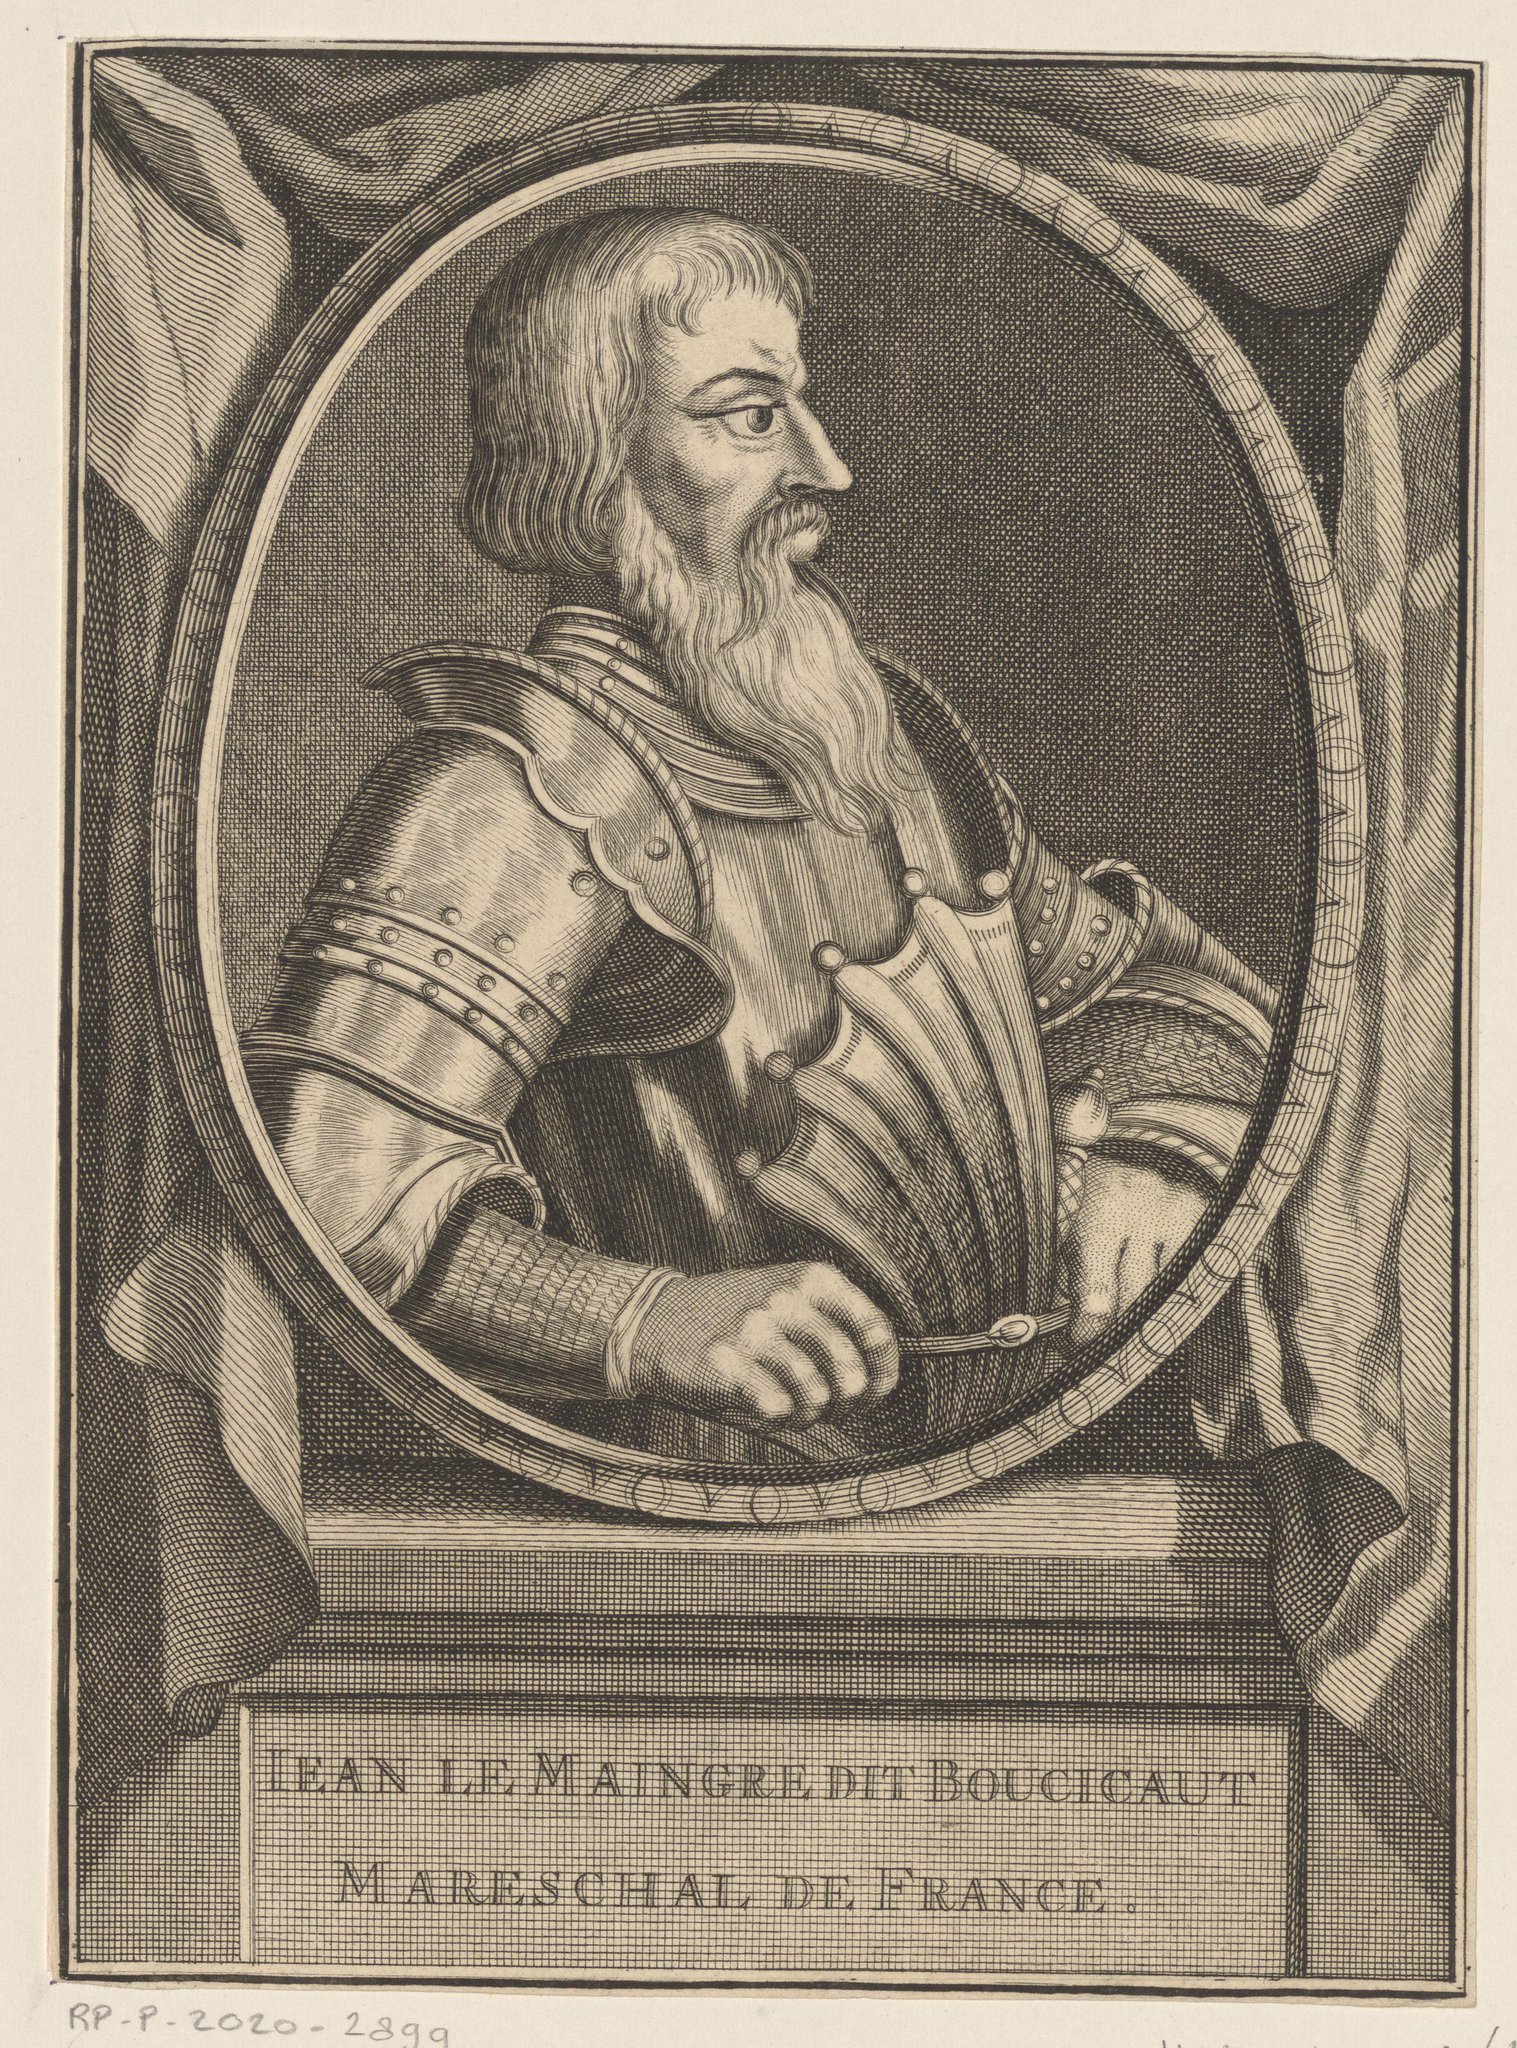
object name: print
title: Portret van Jean II le Meingre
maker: Anonymous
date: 1700-1749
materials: paper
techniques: engraving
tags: commander-in-chief, general, marshal, armour, historical persons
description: Prent mogelijk uit: Lenfant, Jacques. Historie du Concile de Pise (...). Amsterdam: Pierre Humbert, 1724, dl. 1.